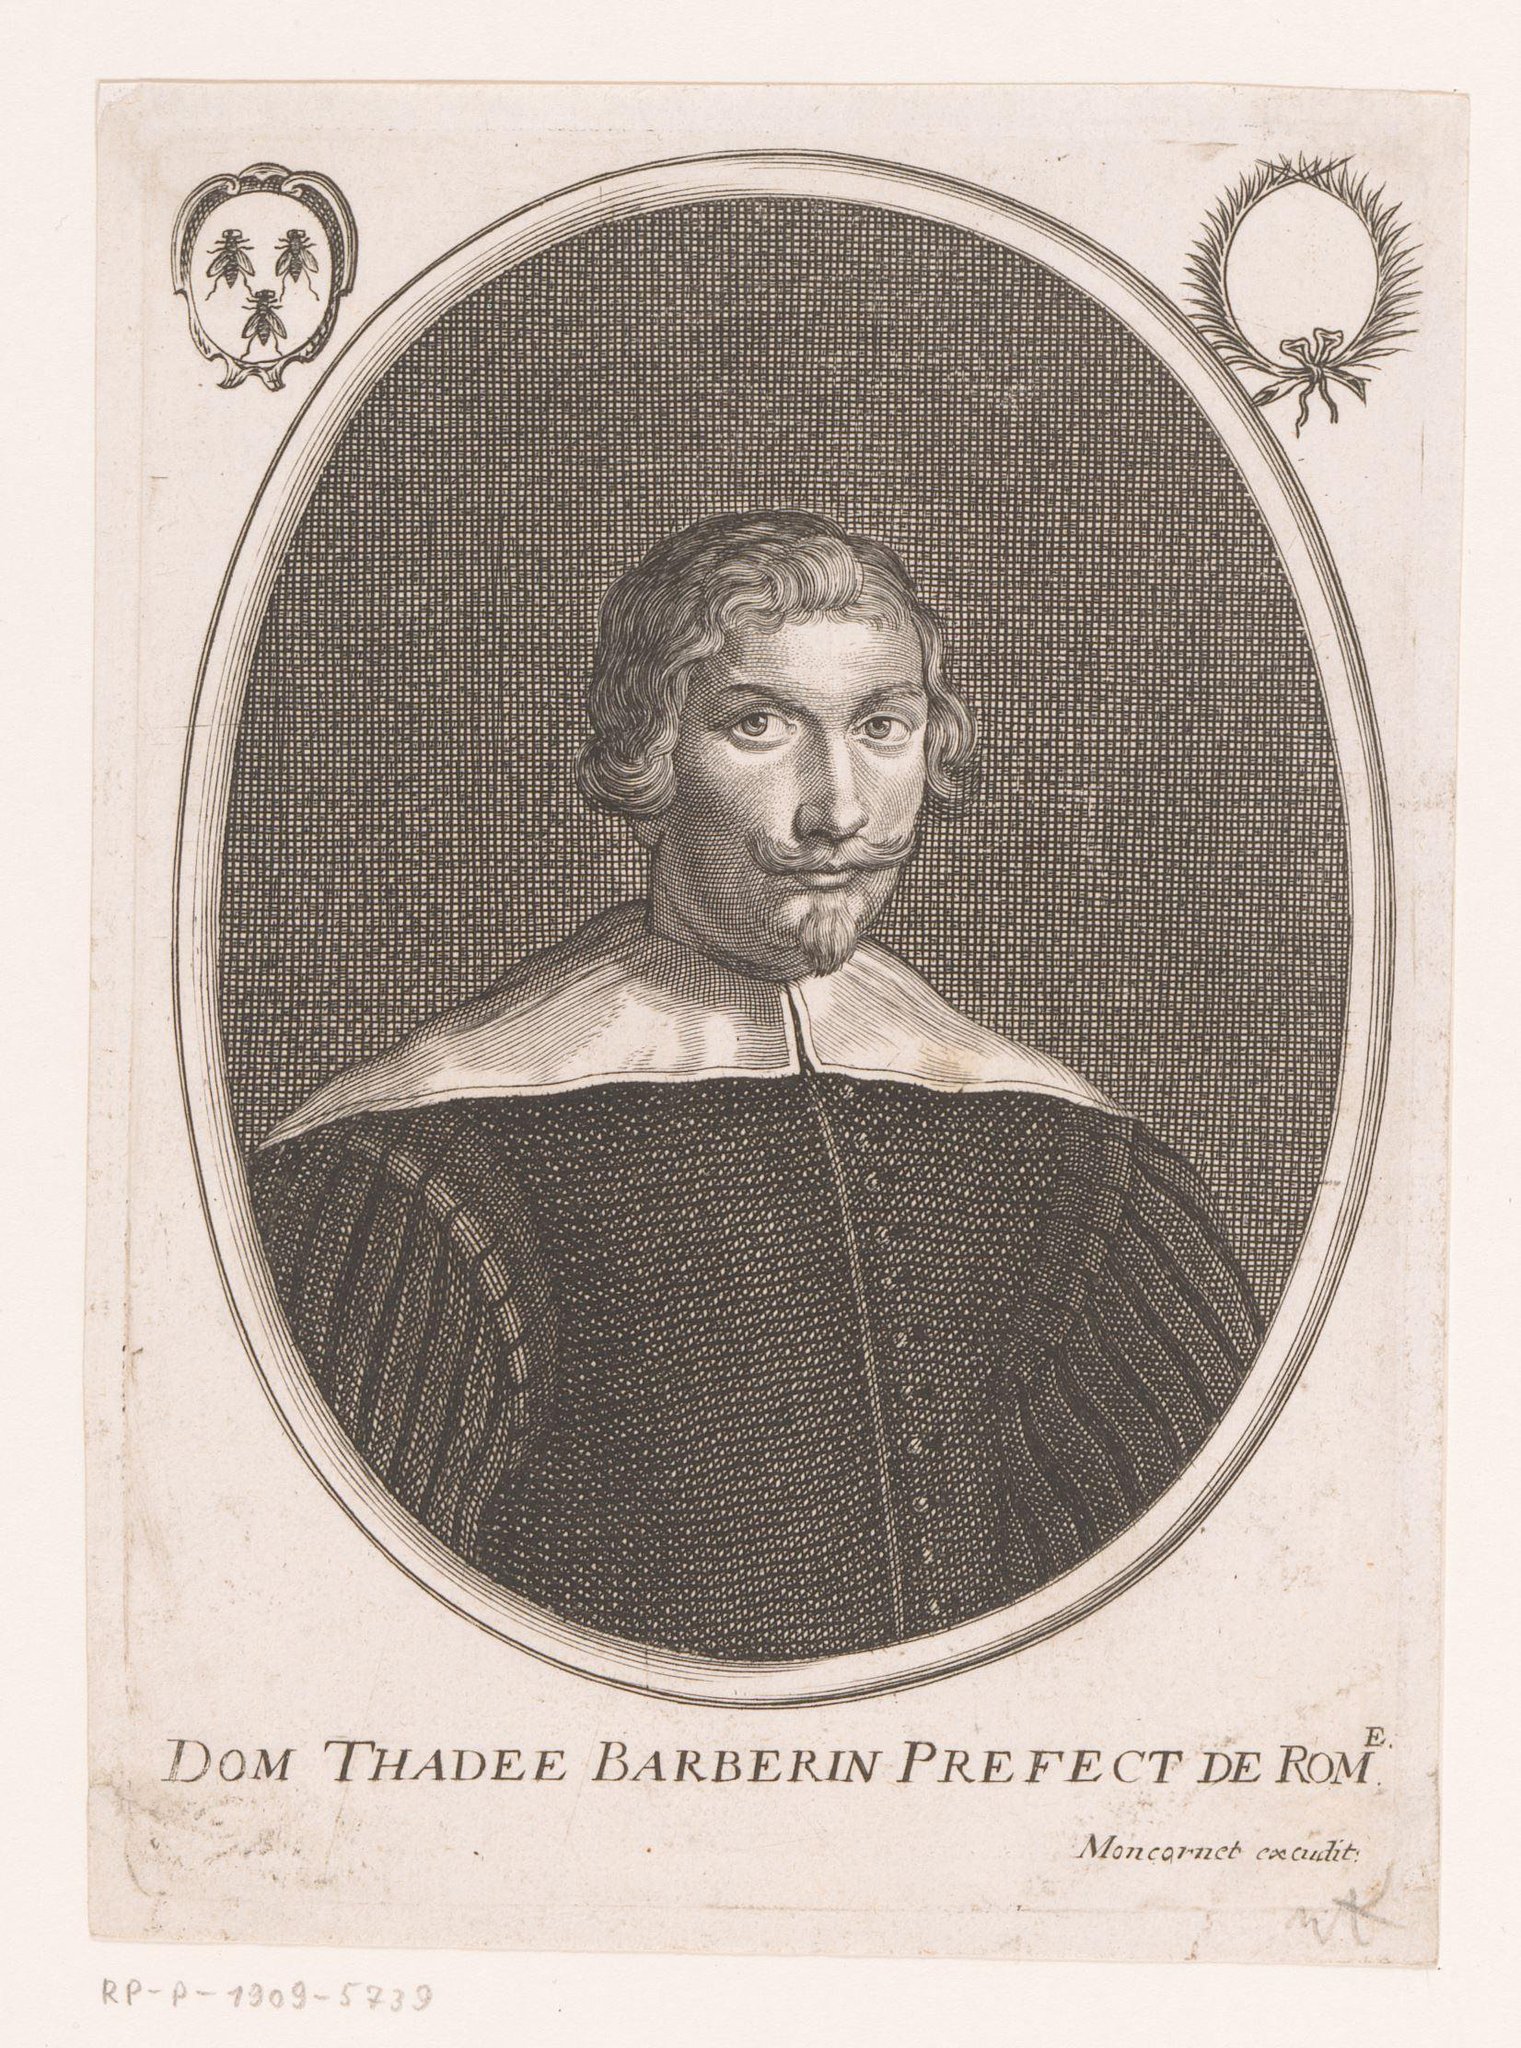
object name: print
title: Dom Thadee Barberin Prefect de Rome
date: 1610-1668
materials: paper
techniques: engraving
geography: paris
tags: rome, paris, taddeo barberini, historical persons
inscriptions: collector's mark: Lugt 2228